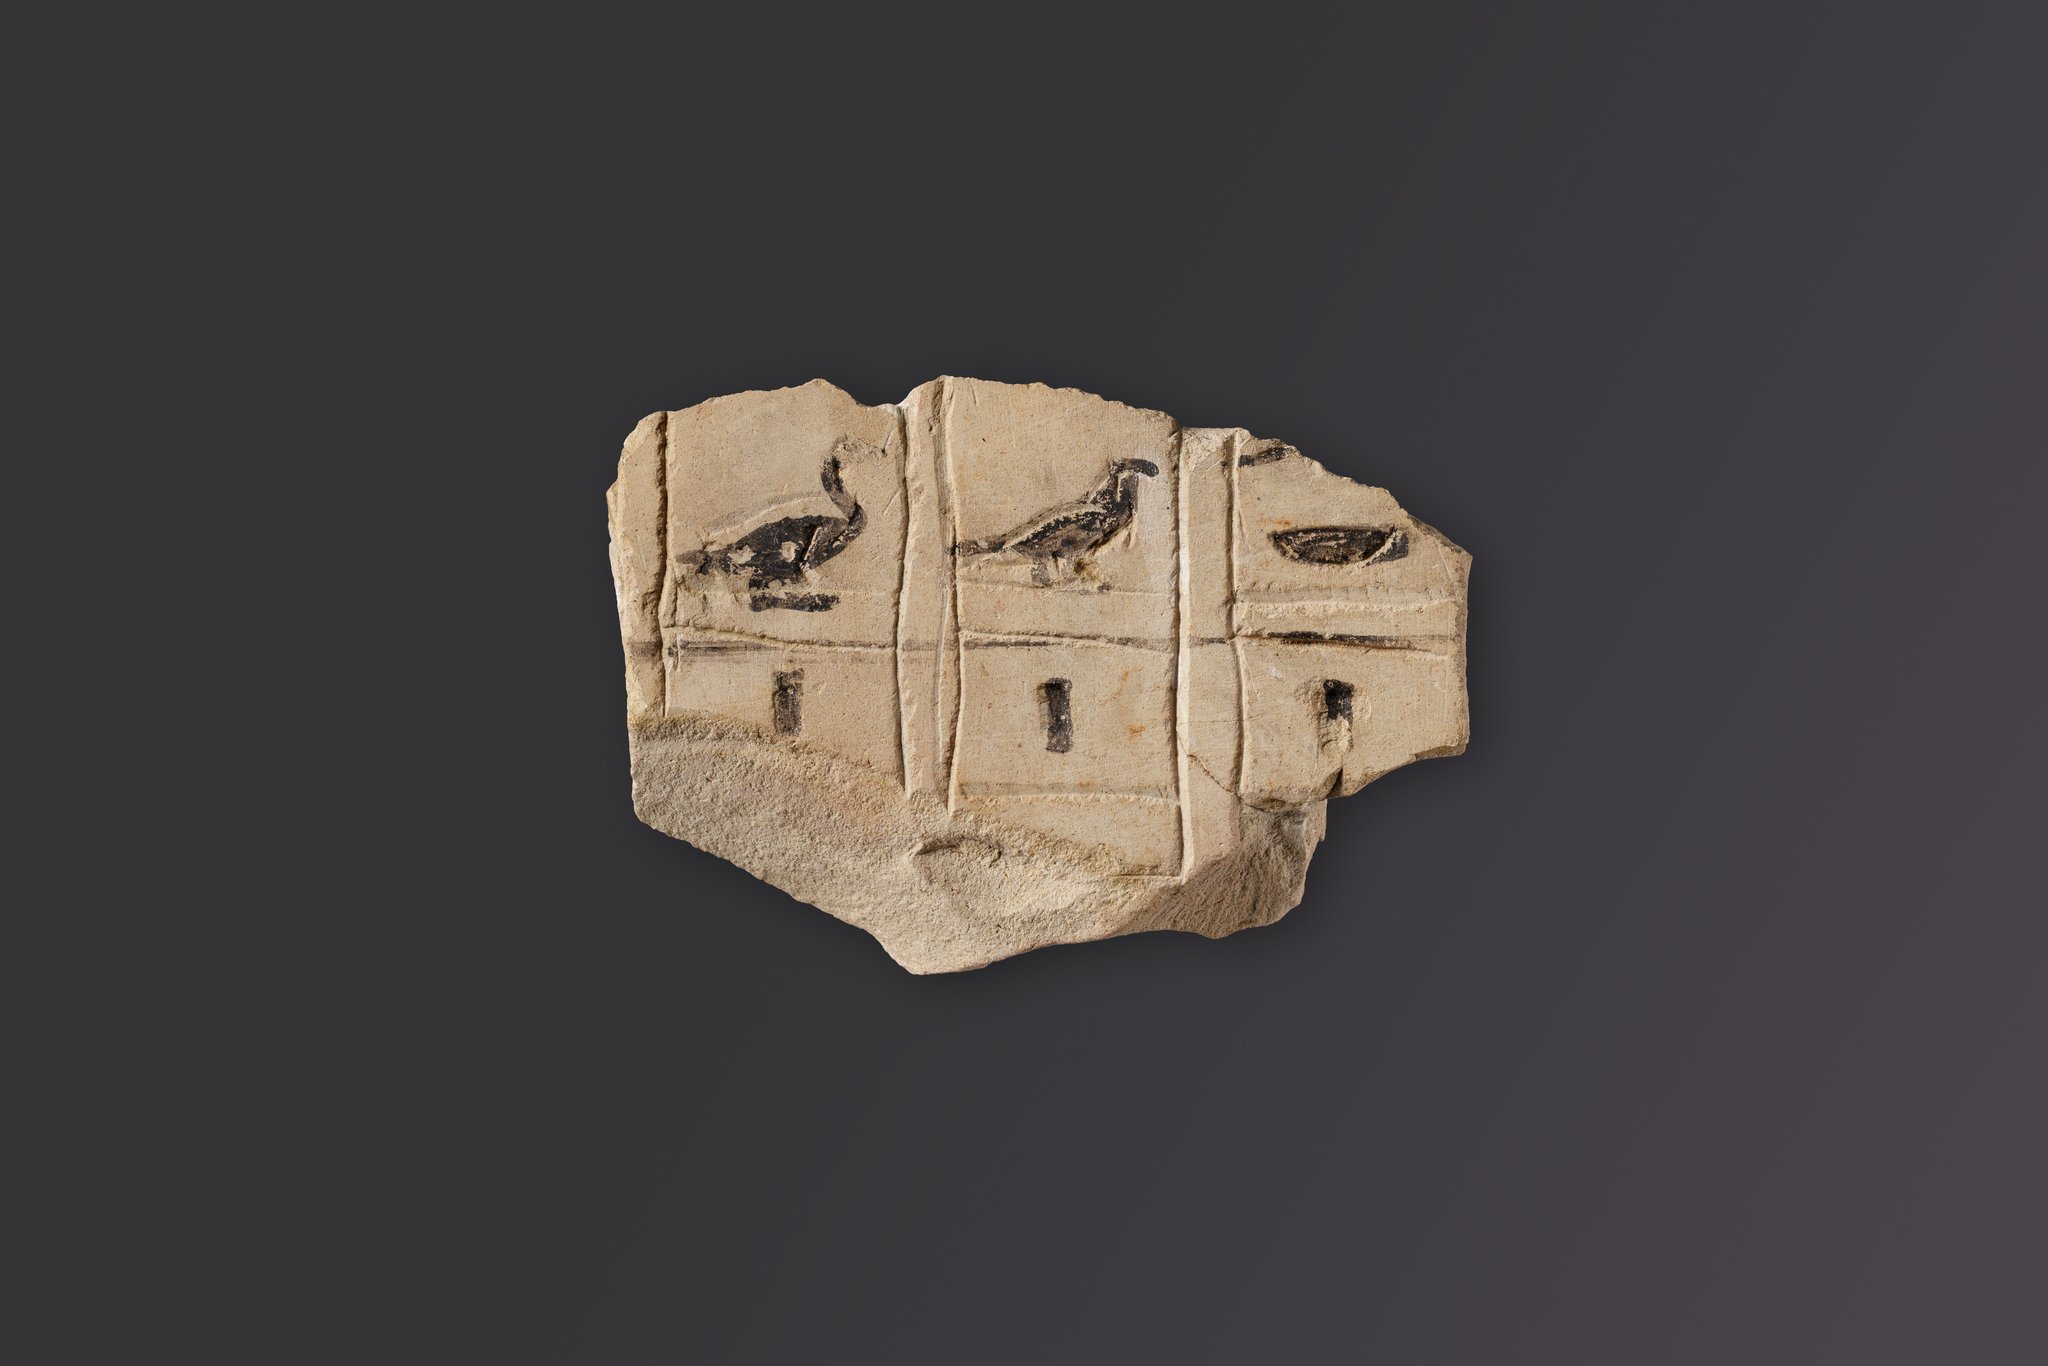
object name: relief fragment, tomb of neferu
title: Fragmentary offering list with mention of unguents and incense; meat, bread, wine; and beer, fowl and desserts. The queen's name is at the lower left.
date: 2051-2030 BCE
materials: limestone, paint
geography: egypt